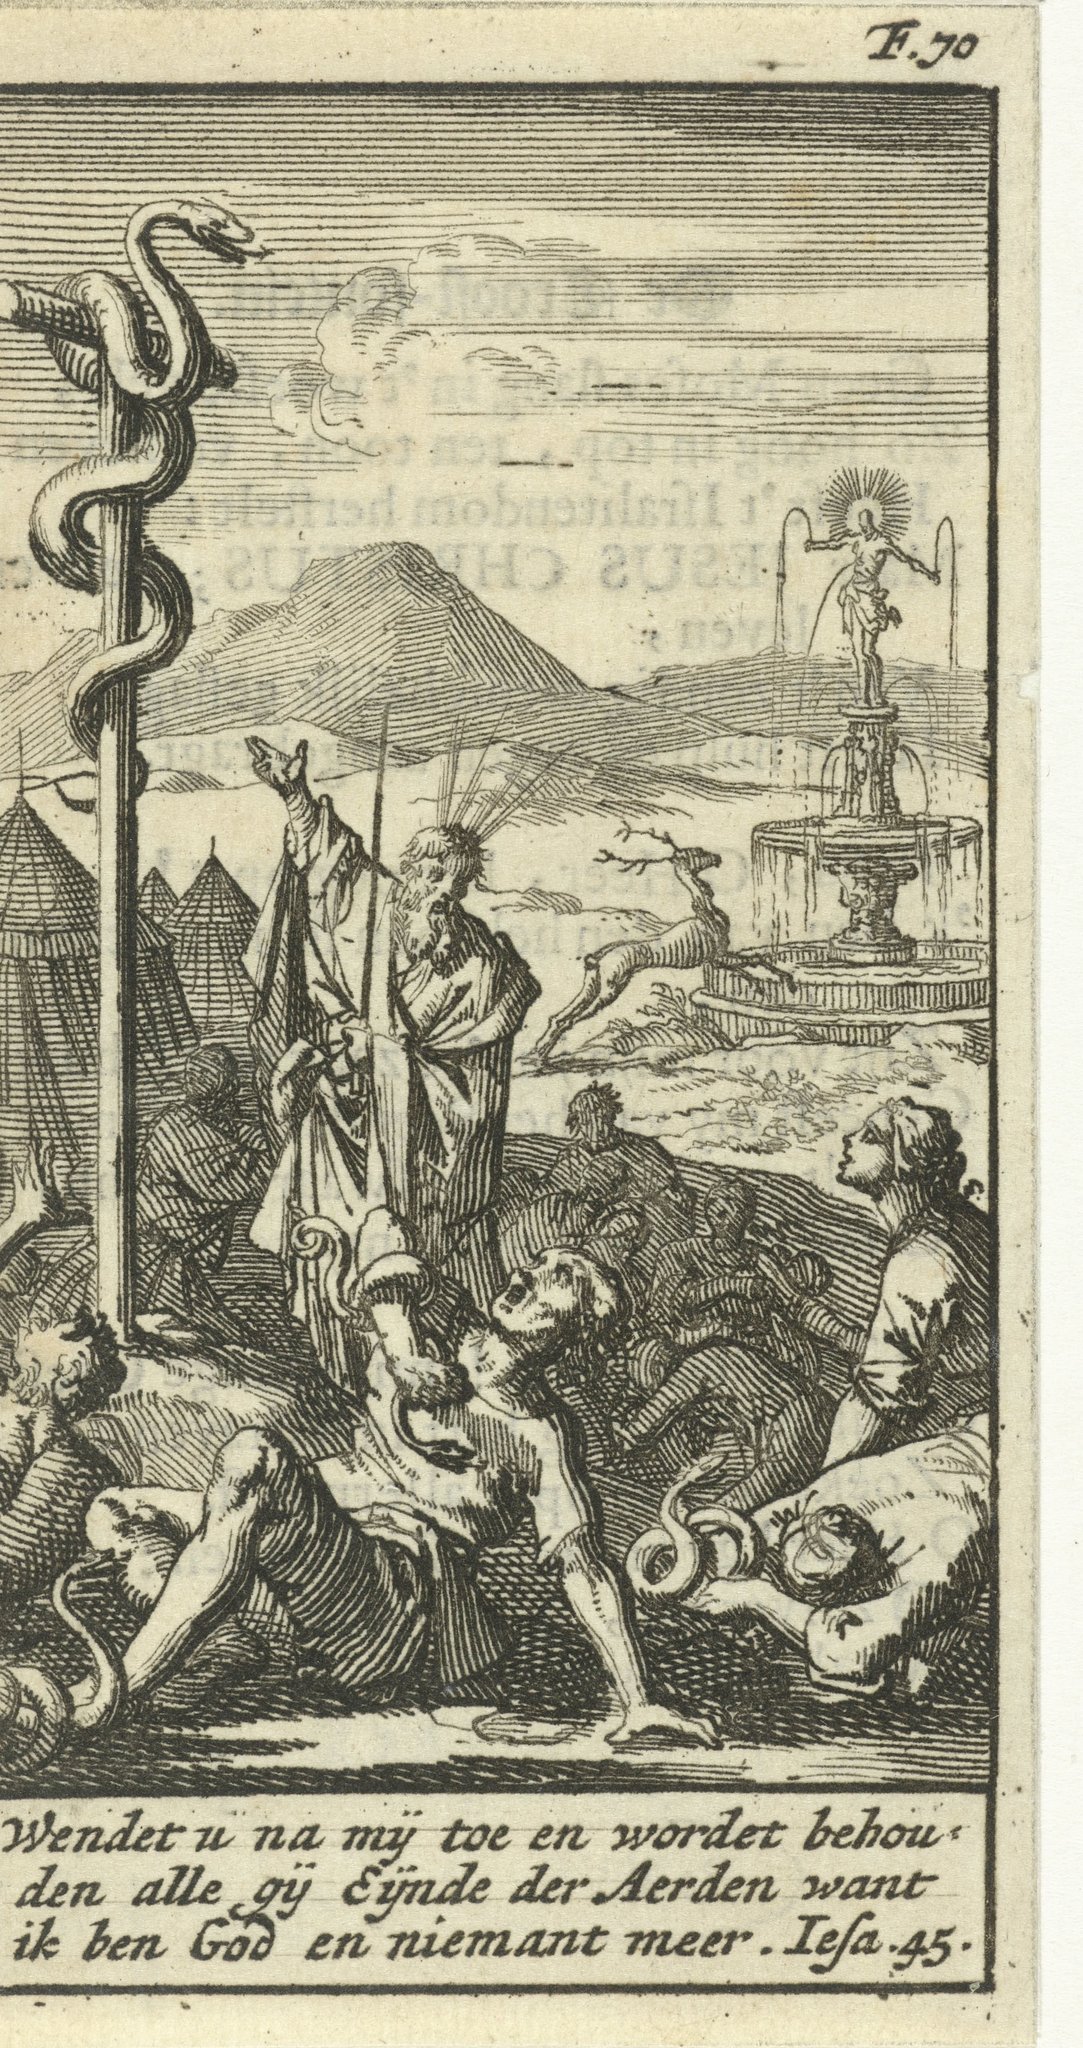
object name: print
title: Mozes toont de koperen slang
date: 1691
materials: paper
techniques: etching, letterpress printing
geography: amsterdam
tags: the brazen serpent (numbers 21:4-9)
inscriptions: collector's mark: Lugt 2228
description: Illustratie uit: Hakvoord, Barend. Het heilige avondmaal, van onzen Heer en Zaligmaker Jesus Christus. Amsterdam: Gijsbert de Groot, 1691.